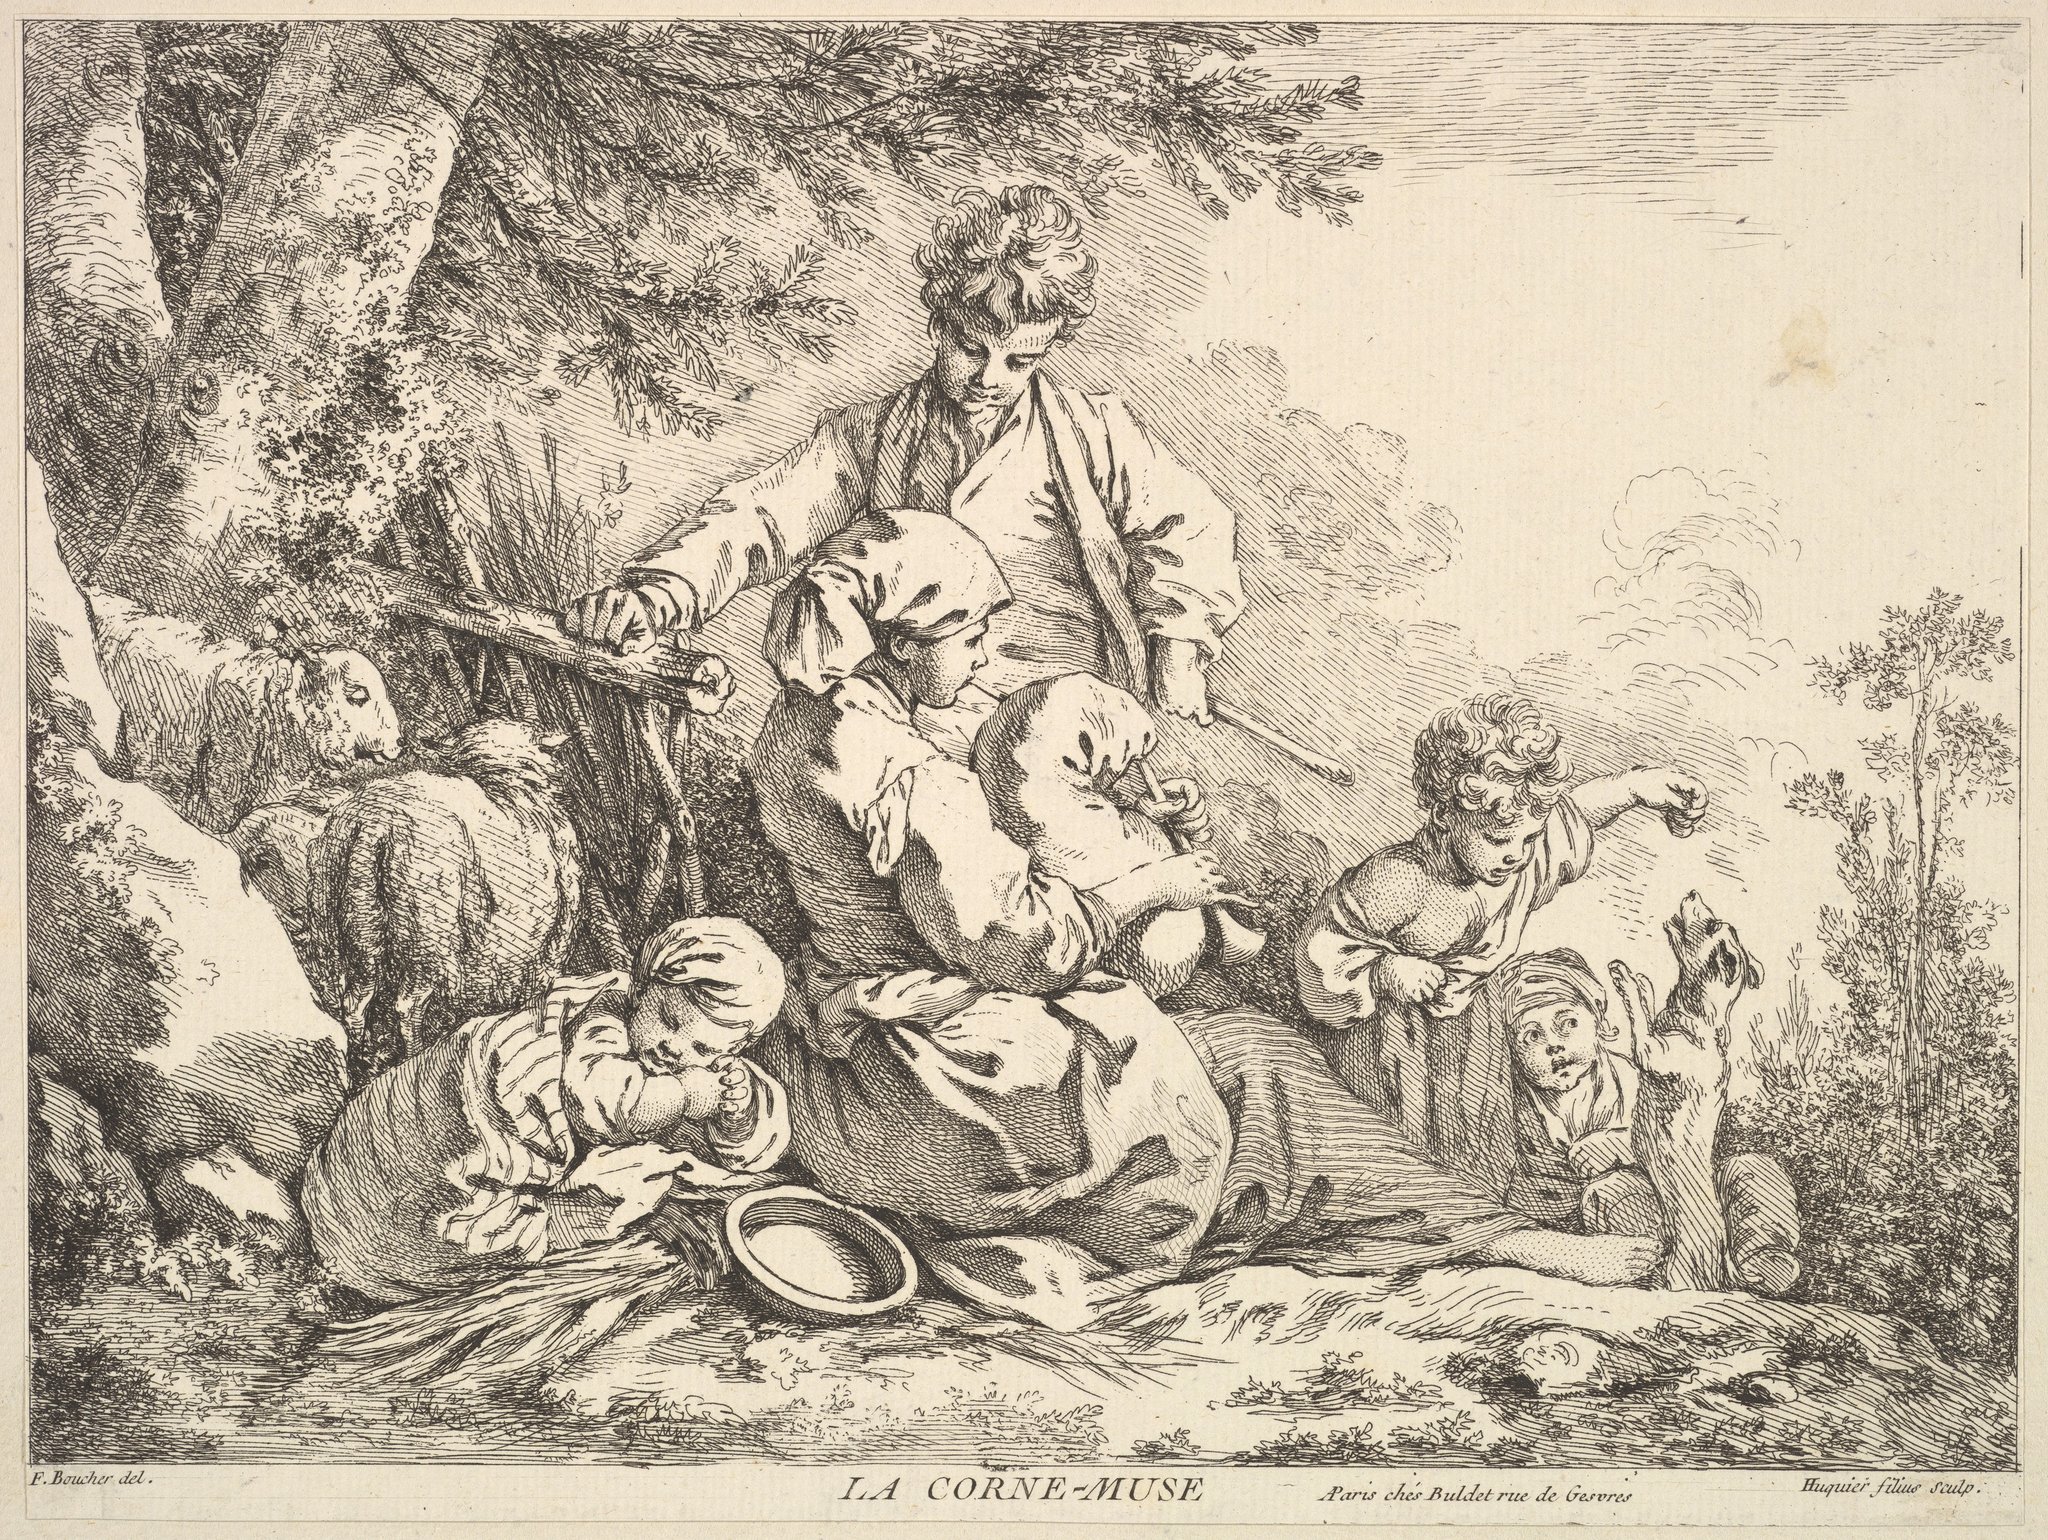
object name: print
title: Bagpipes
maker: jacques gabriel huquier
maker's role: artist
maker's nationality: french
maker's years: 1730-1805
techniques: engraving, etching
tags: boys,men,women,bagpipes,dogs